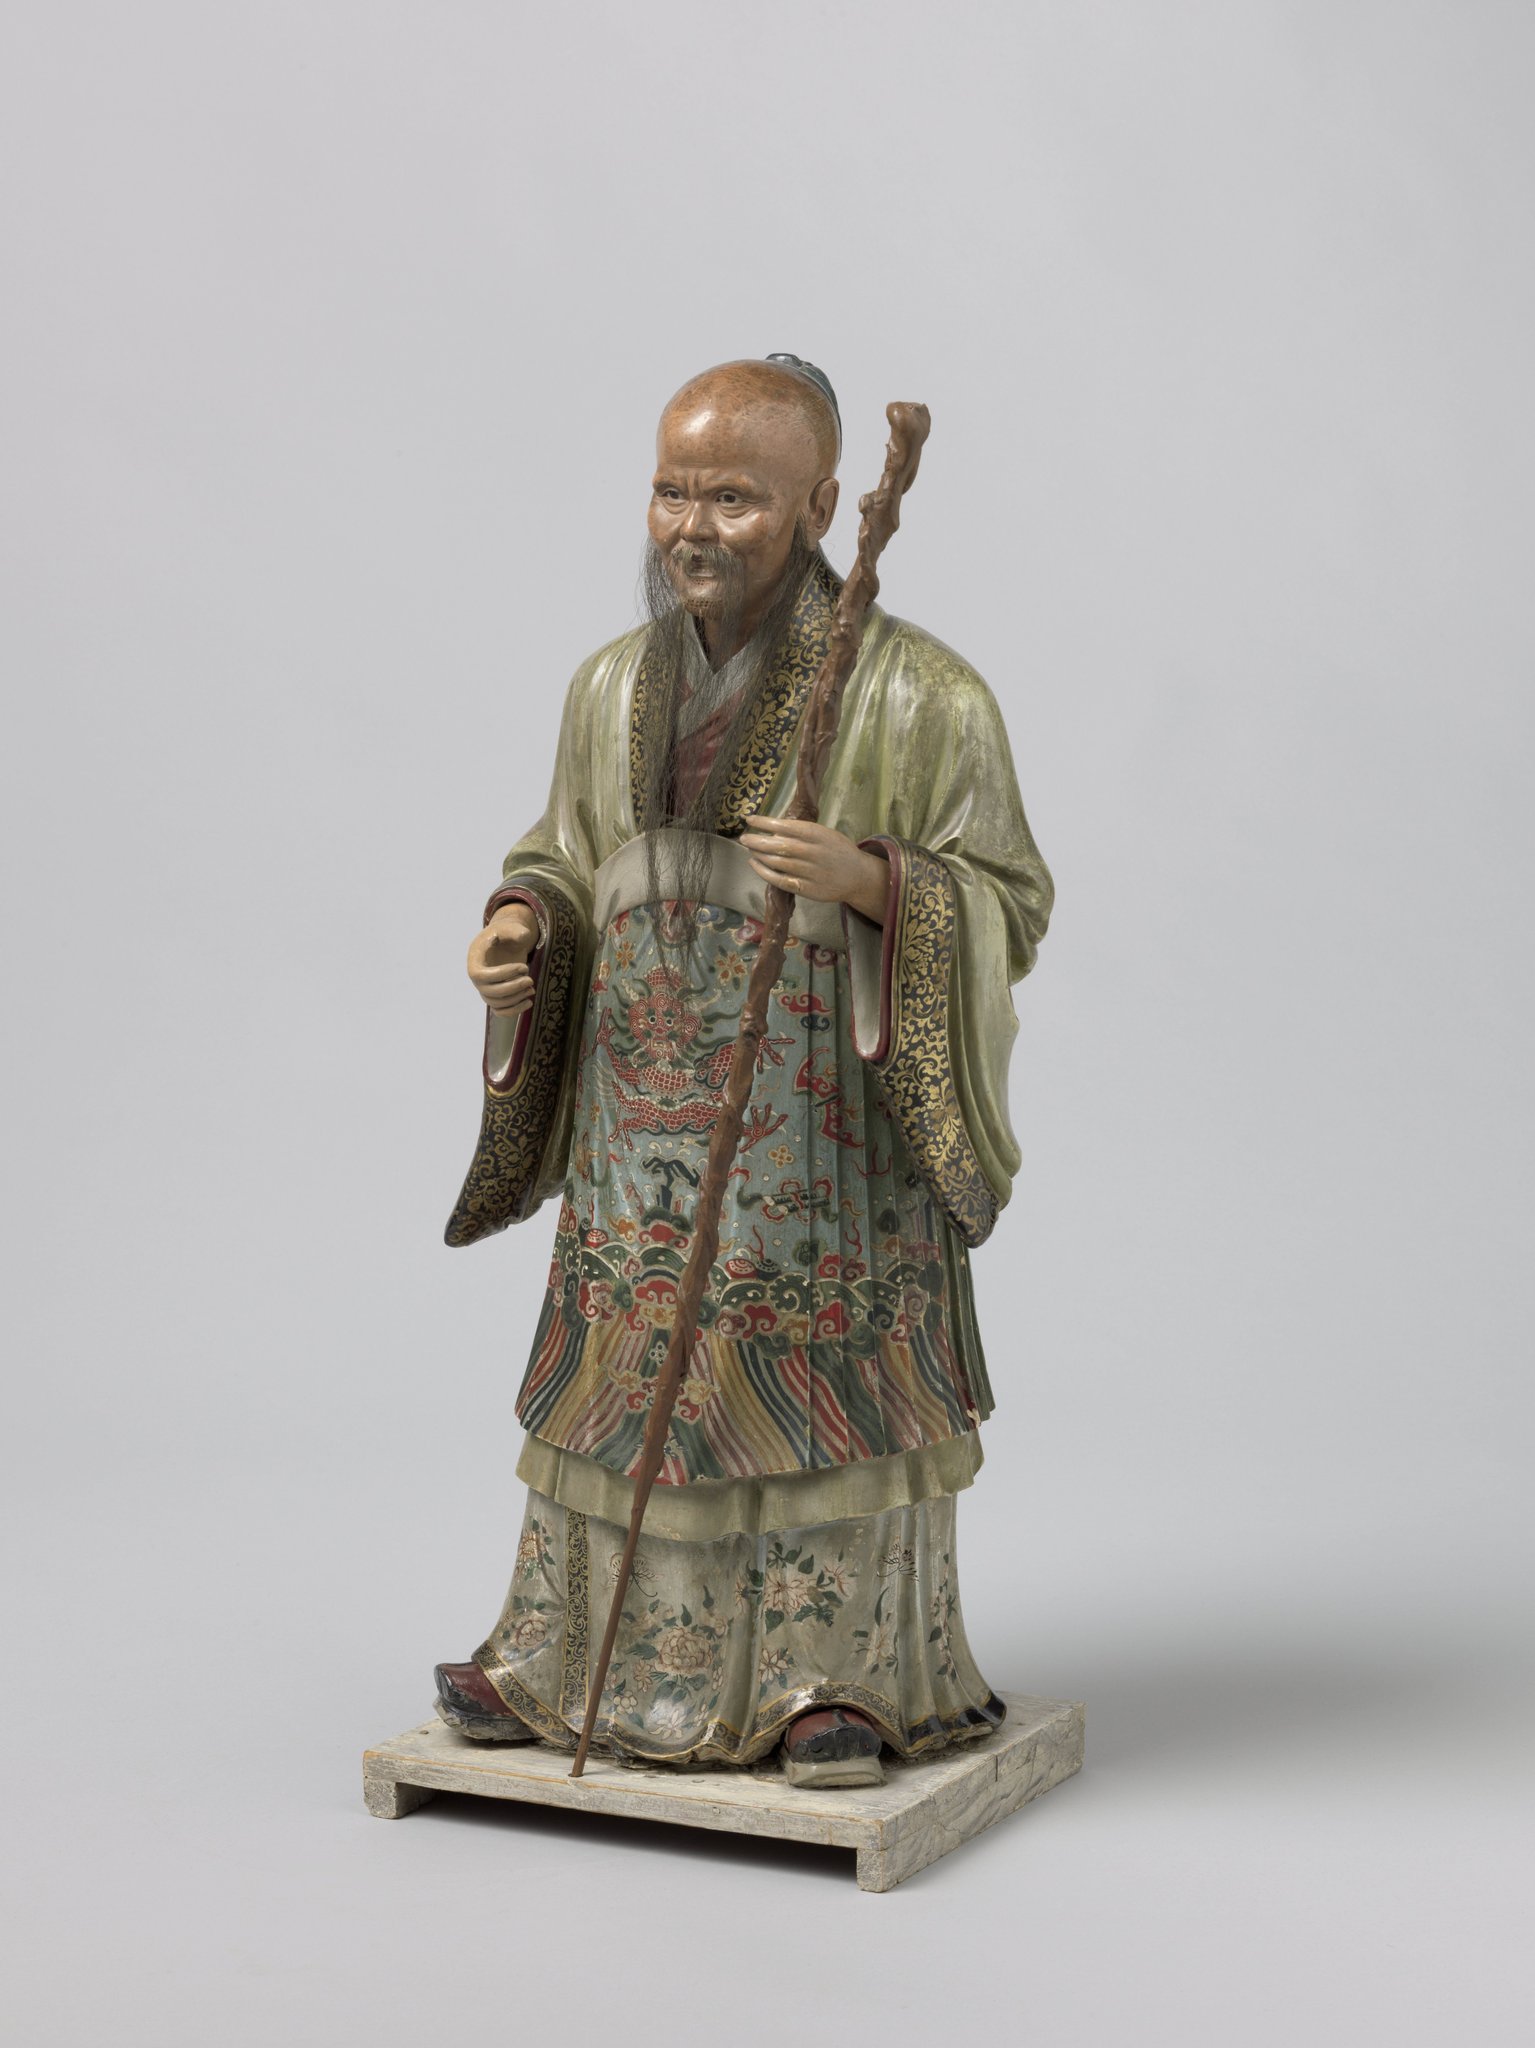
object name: doll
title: Nodding head figure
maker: Anonymous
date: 1804-1808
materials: hair, iron, lead, earth, porcelain, wood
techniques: woodworking, molding, polychromy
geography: china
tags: china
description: Chinese clay figures, ca. 1805. Present of the Chinese Emperor to the visiting Dutch official A.H. van Limburg Stirum Brouwer, from 1804 untill 1808 member of the Dutch council which ruled the Asian colonies. The figures are made of painted clay an have nodding heads. They depict a Chinese mandarin and his wife. His hair and the dragon on his chest show his high rank. The feet of the woman have been tied off to fit in very small shoes, then a token of female beauty in China.